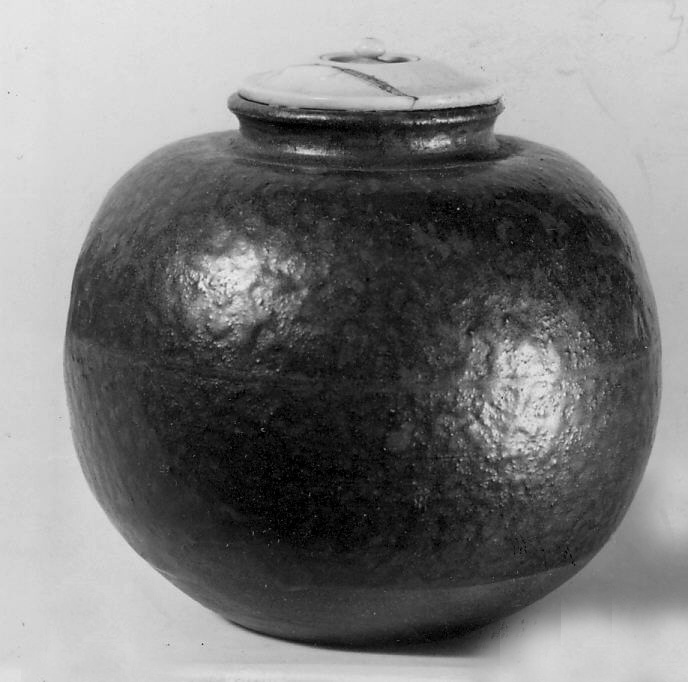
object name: tea jar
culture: japanese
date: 1701-1800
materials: clay, glaze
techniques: overglaze